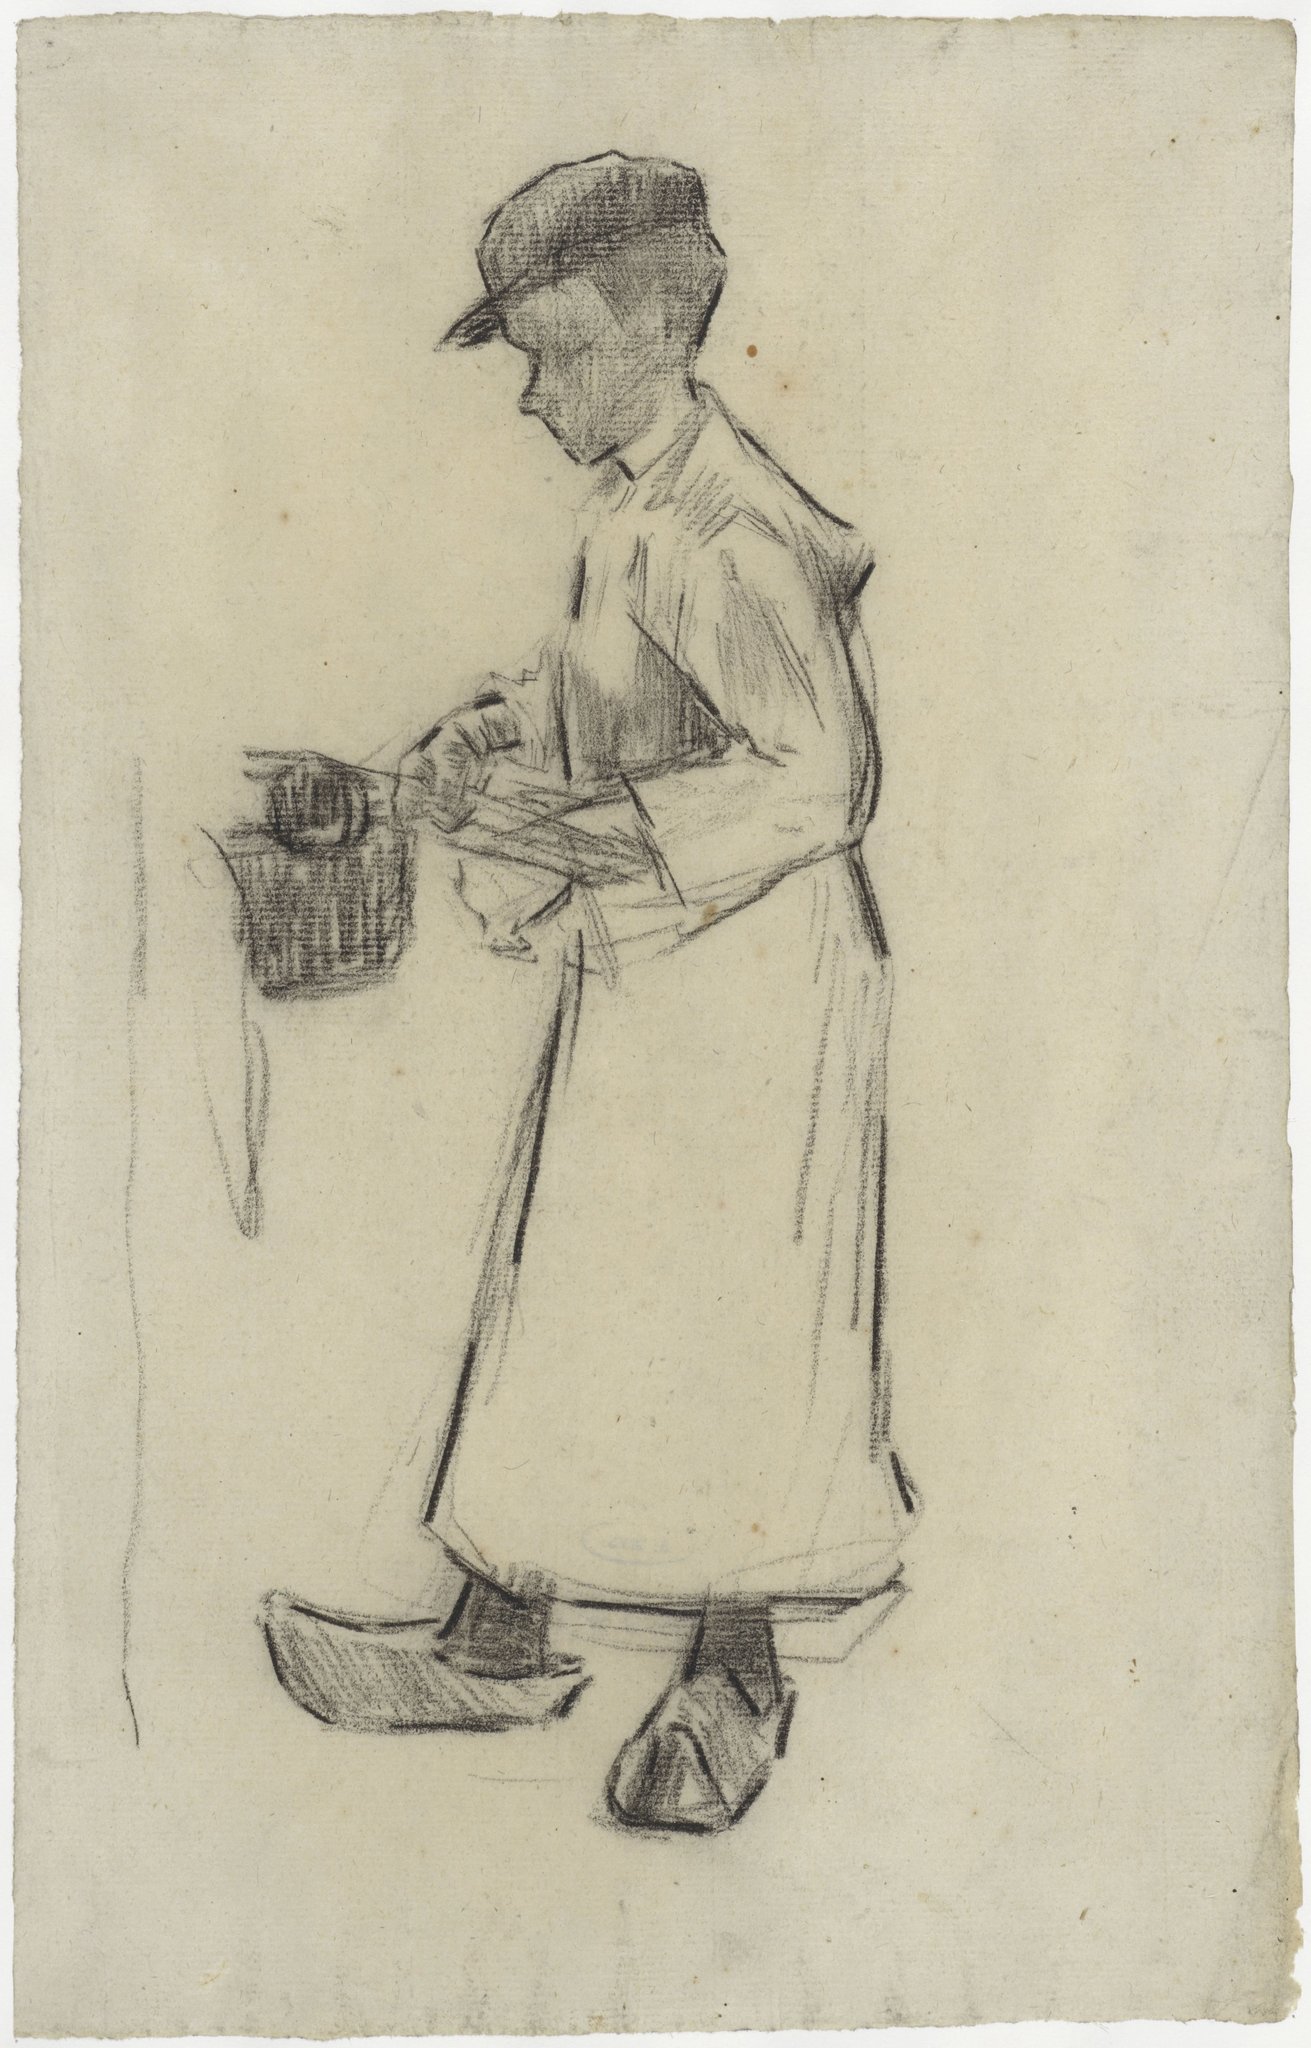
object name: drawing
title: Fabrieksjongen aan het werk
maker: anthon gerhard alexander van rappard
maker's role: draughtsman, print maker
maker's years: 1858-1892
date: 1868-1892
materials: charcoal, paper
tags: industries (+ children (labourers)), child labour